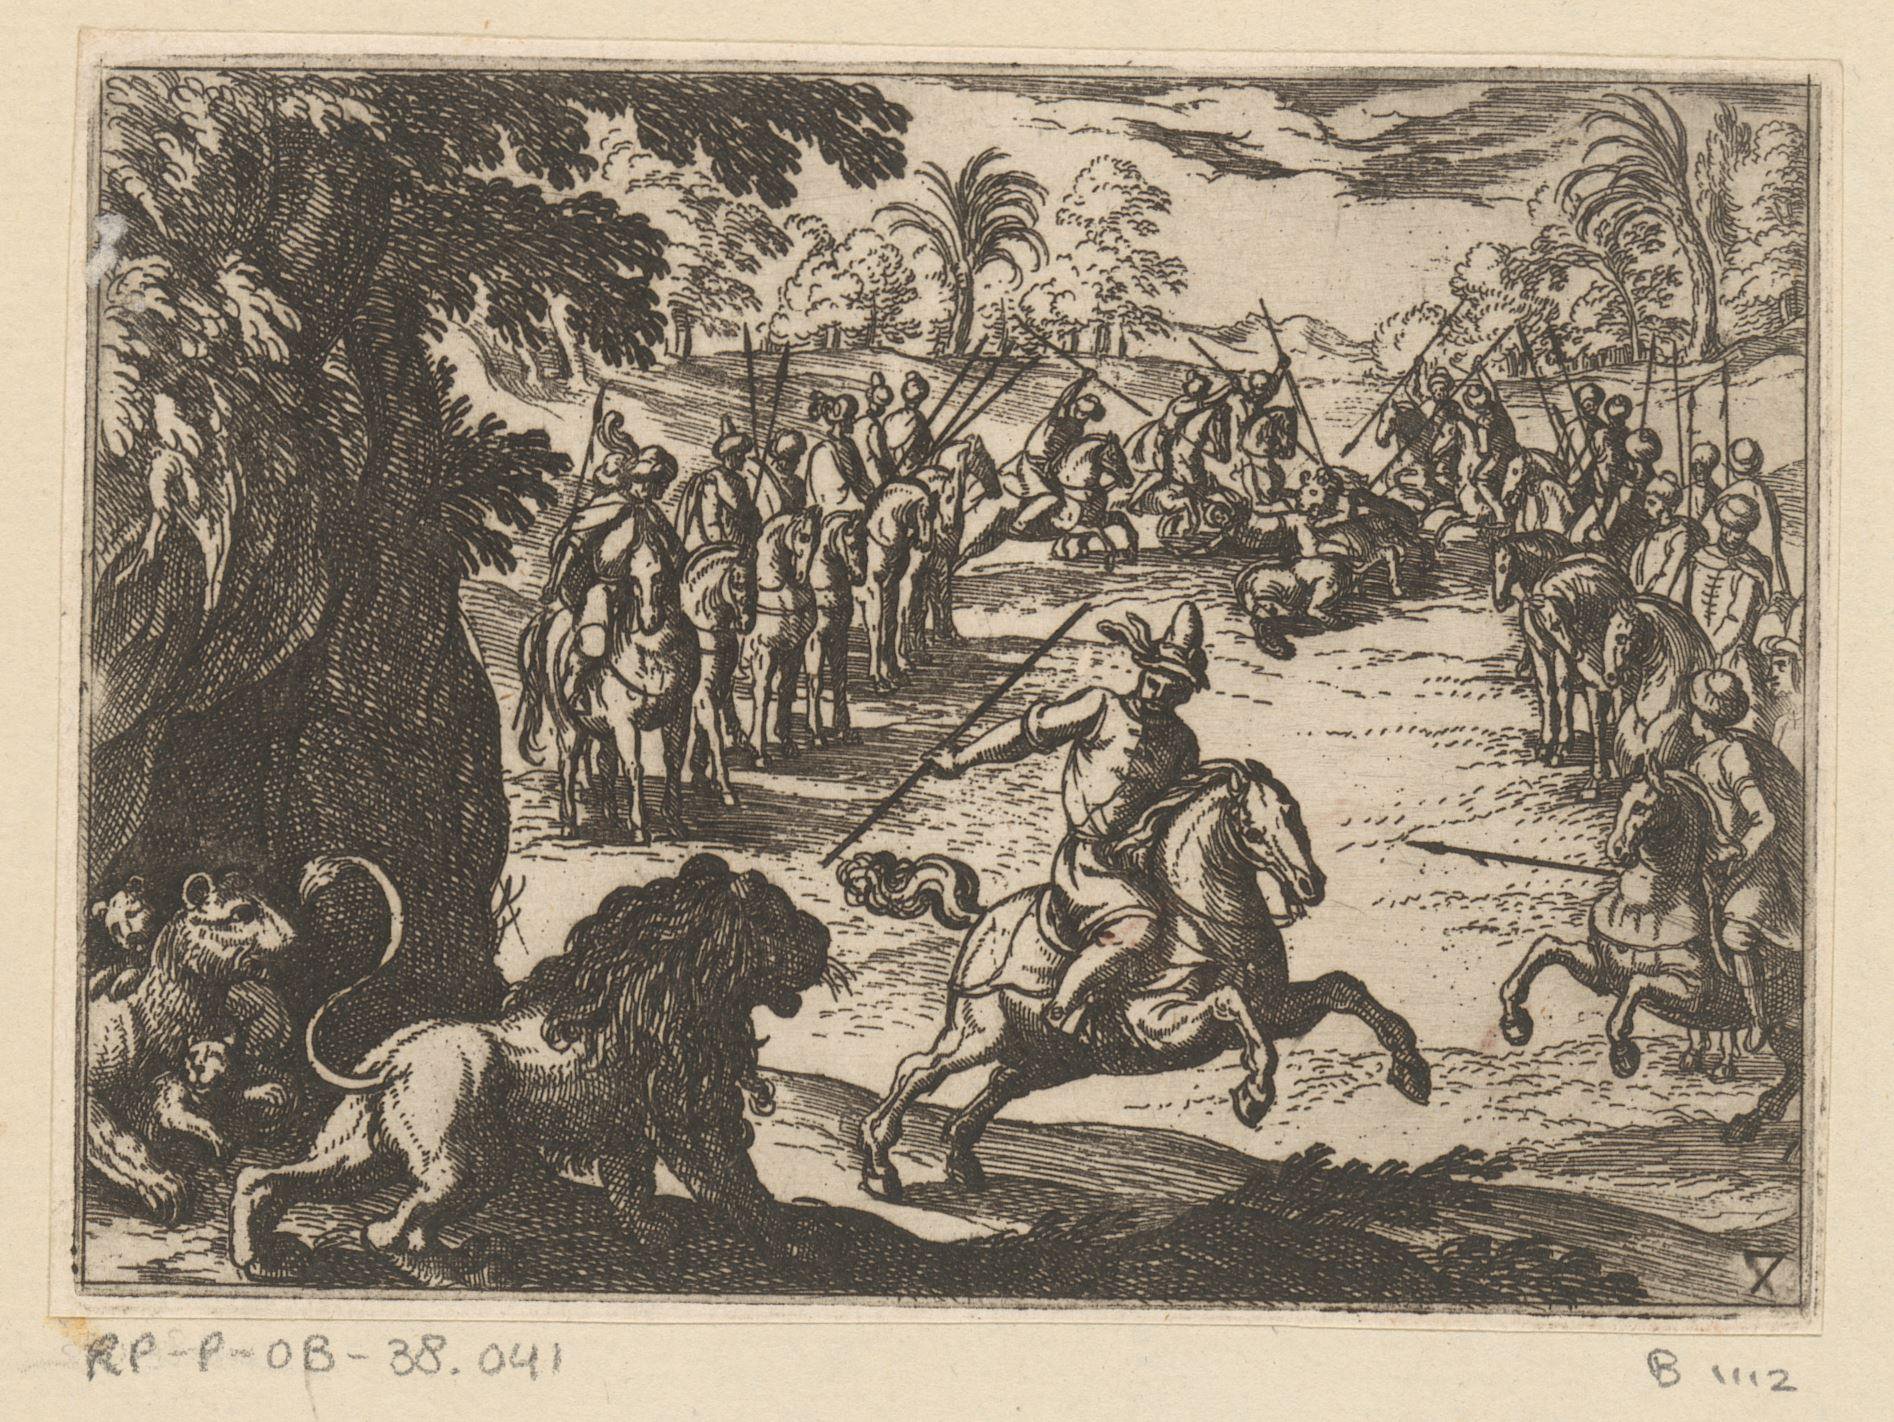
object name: print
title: Jacht op leeuwen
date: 1598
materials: paper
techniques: etching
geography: italy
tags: lion hunt, hunter, hunters hunting (n.b.: in 1988-1990 this notation denoted the concept of 43c11421 'hunters resting during the hunt')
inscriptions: collector's mark: Lugt 240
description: Deze prent maakt deel uit van een reeks van vijftien prenten met jachtscènes (+ opdracht).